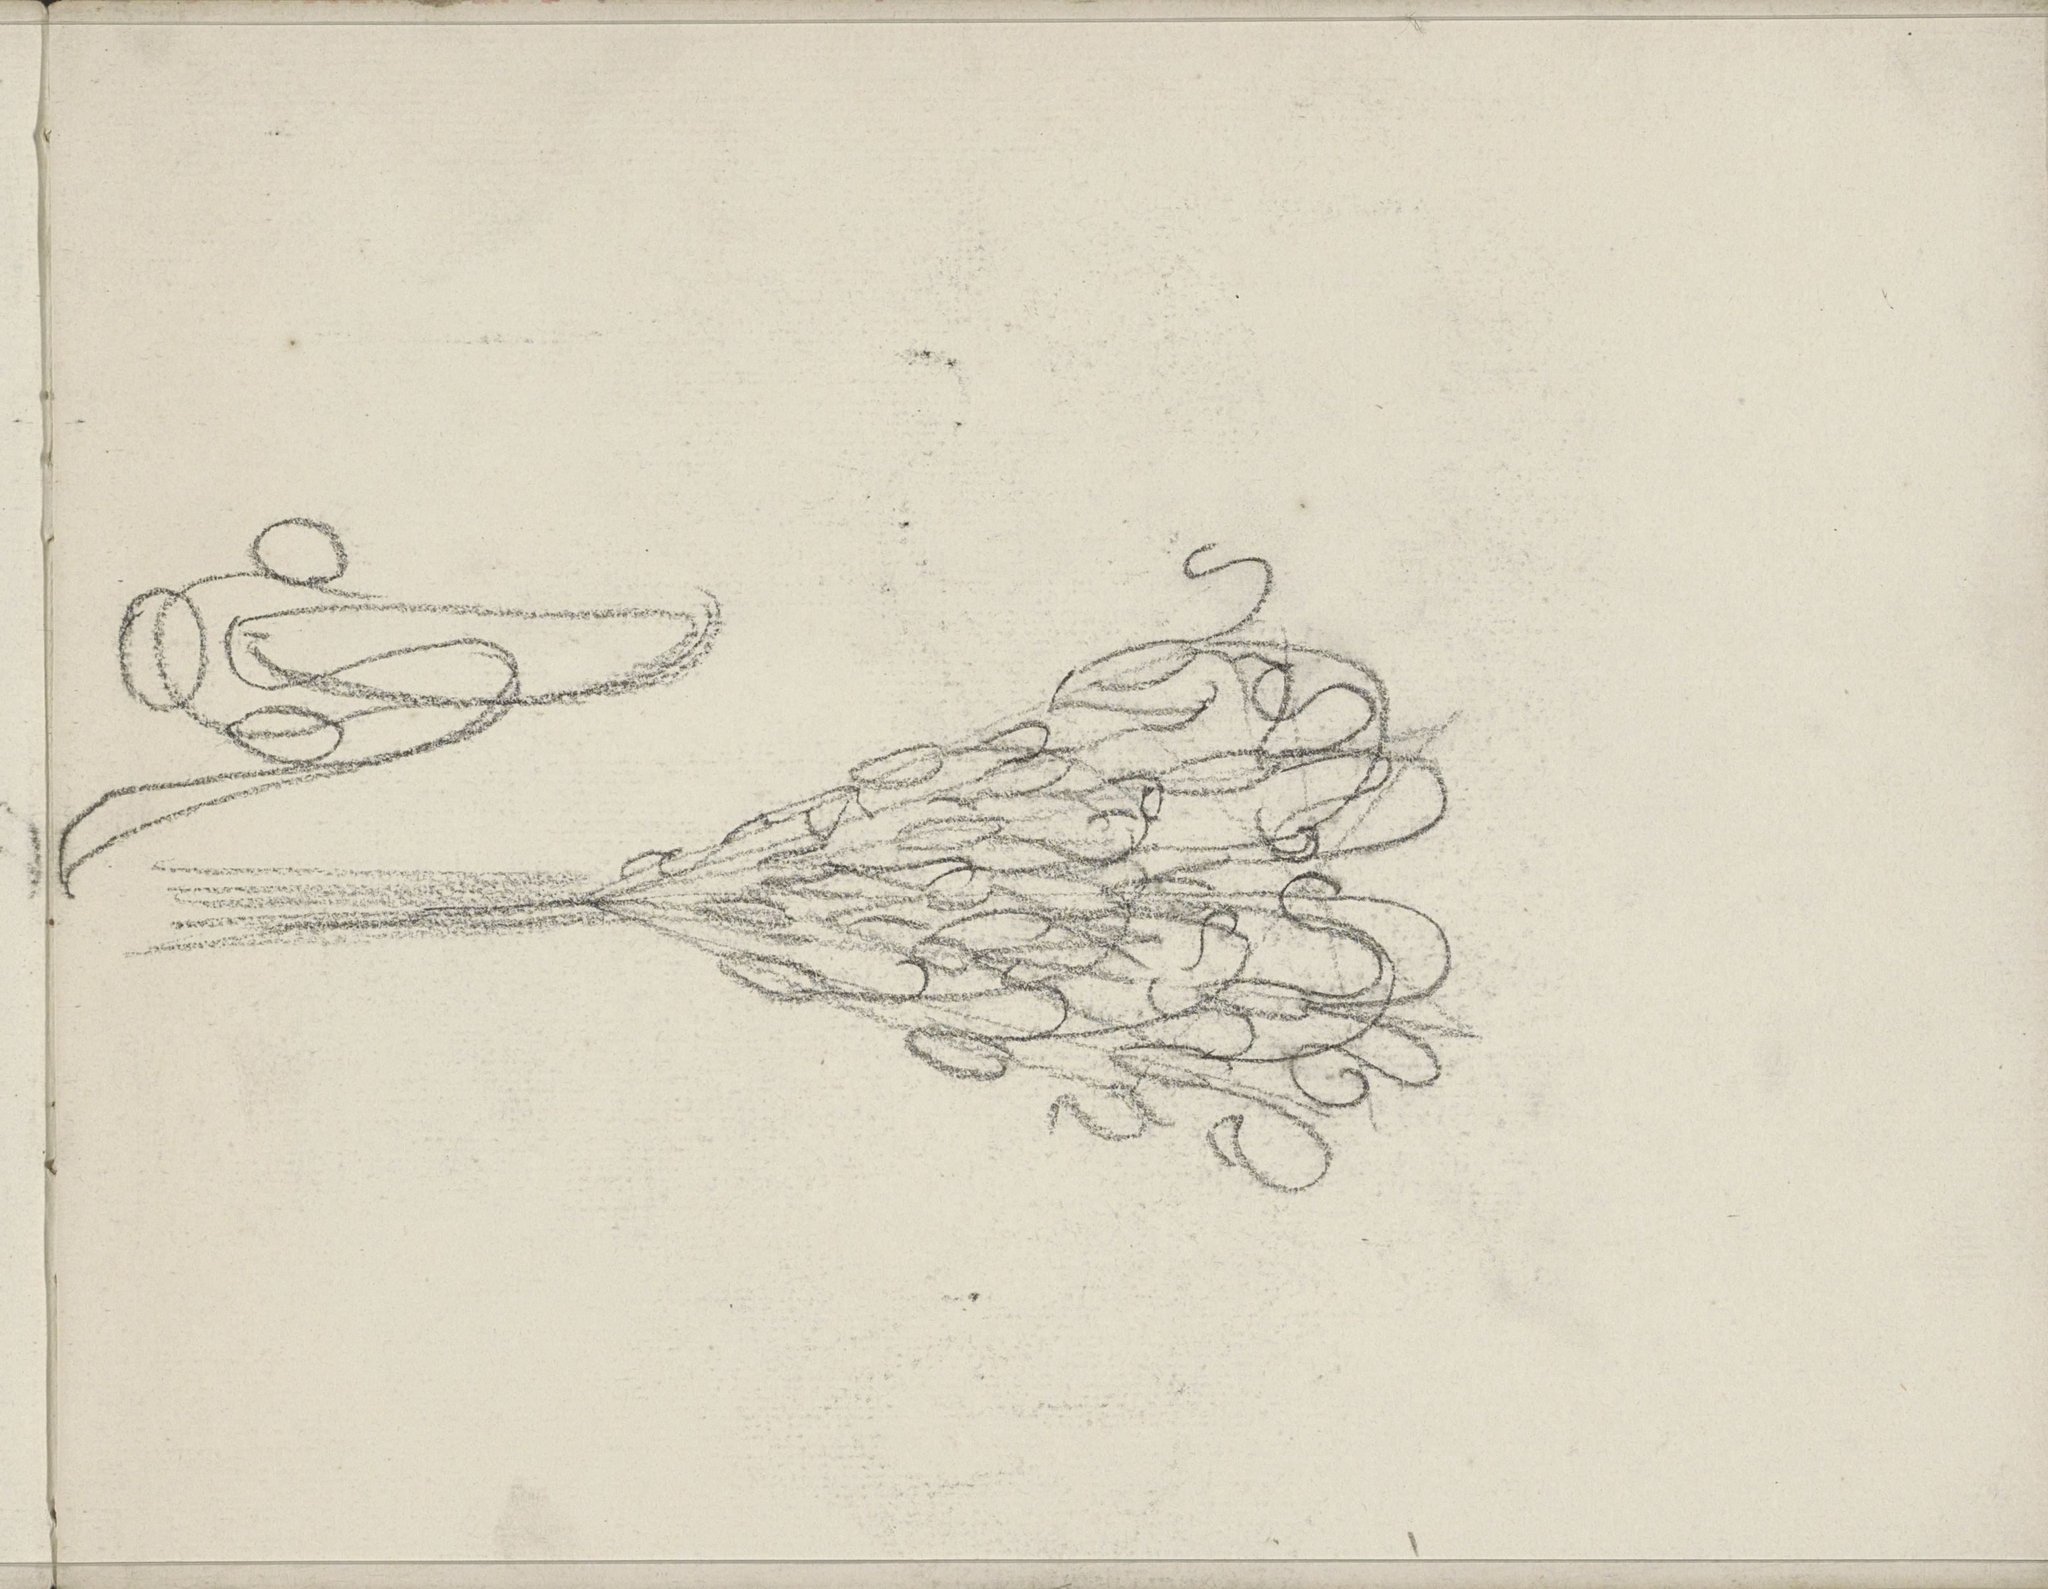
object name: sketchbook leaf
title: Studie, mogelijk een lamp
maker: carel adolph lion cachet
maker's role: draughtsman, print maker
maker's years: 1864-1945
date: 1896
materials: chalk, paper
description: Blad 32 recto uit een schetsboek met 44 bladen.